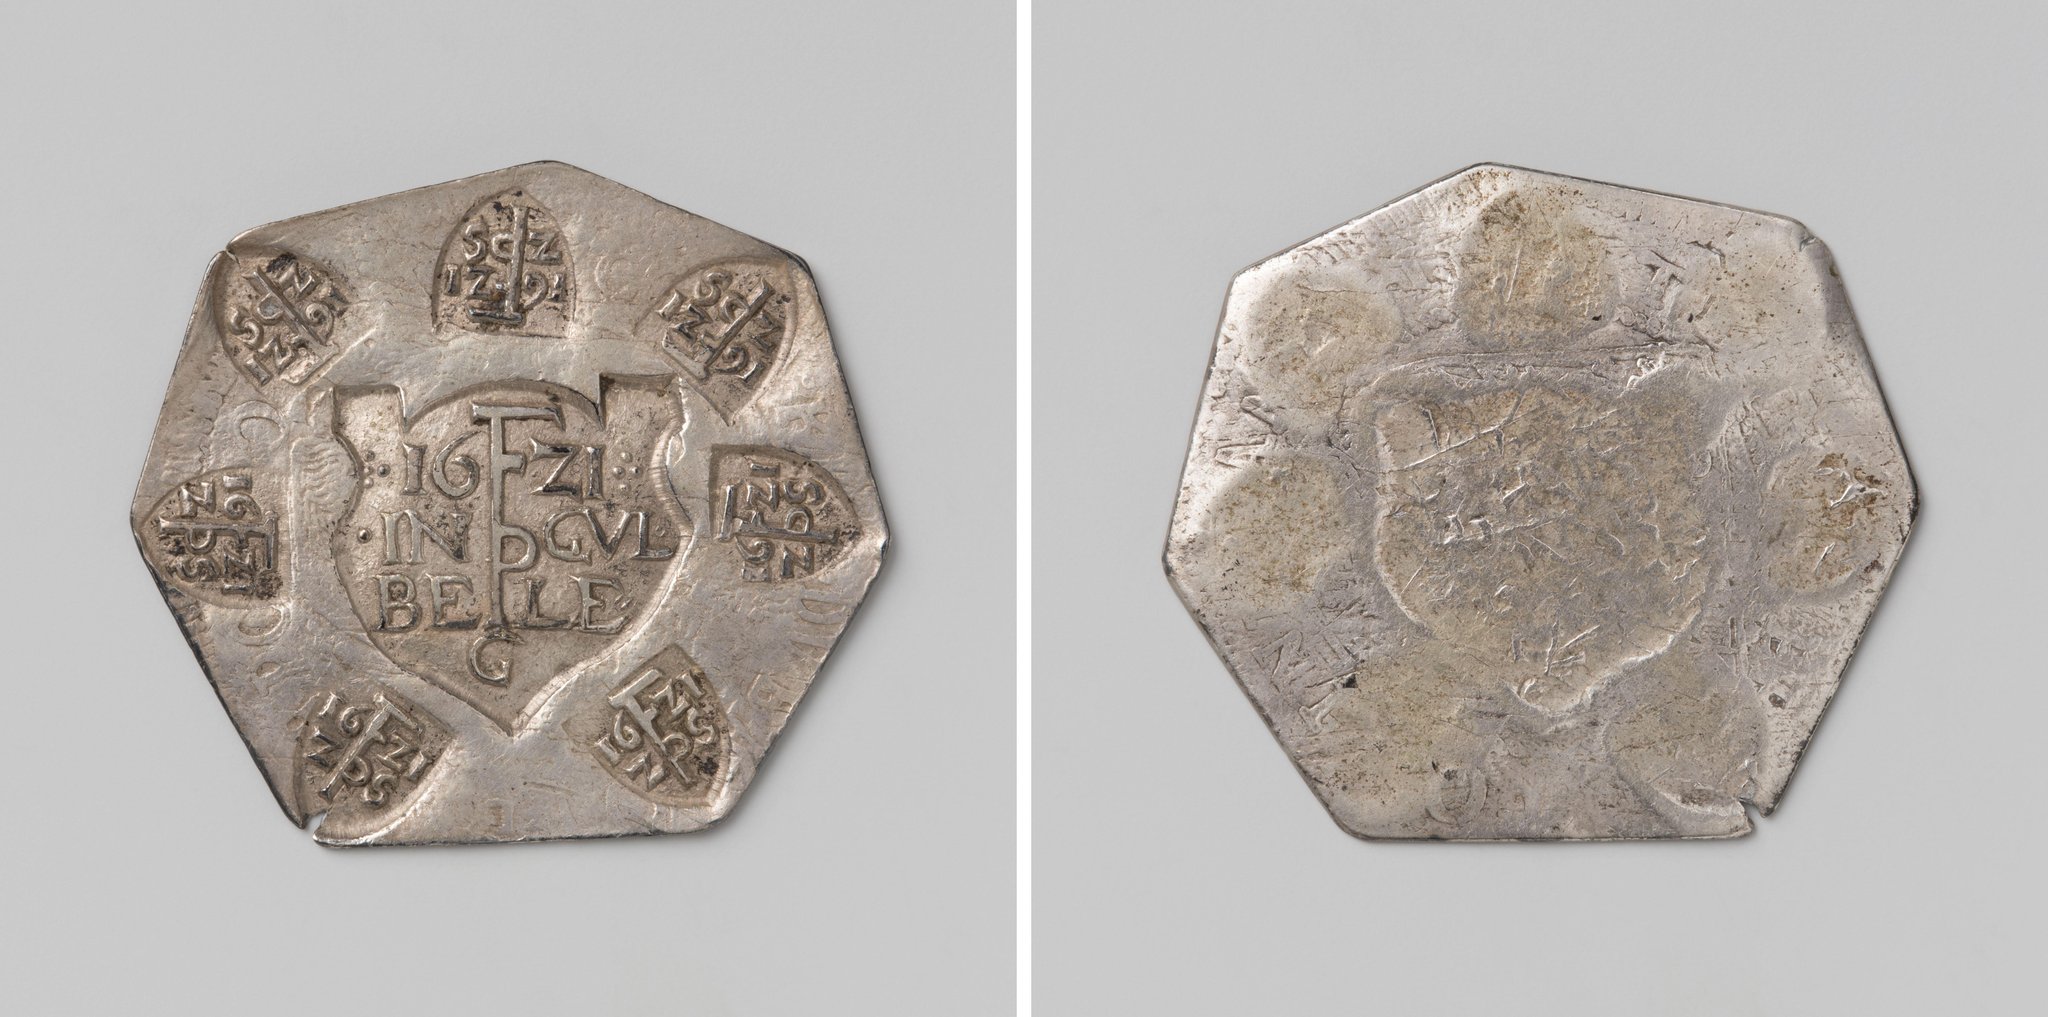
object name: coin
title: Beleg van Gulik door Albrecht, aartshertog van Oostenrijk, noodmunt met het gewicht van een kwart rijksdaalder, vervaardigd uit Dicken van Johann II, graaf van Pfalz-Zweibrucken, bestempeld met het mo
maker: Anonymous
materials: silver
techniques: snipping, striking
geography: gulik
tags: brussels, albrecht aartshertog van oostenrijk